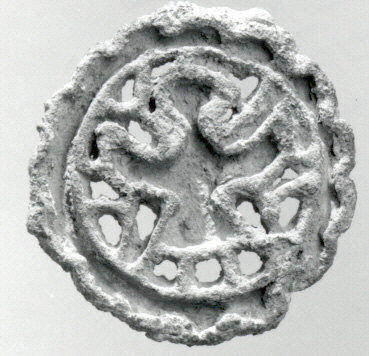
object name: stamp seal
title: Compartmented stamp seal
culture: bactria-margiana archaeological complex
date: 2333-1668 BCE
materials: copper alloy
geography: bactria-margiana